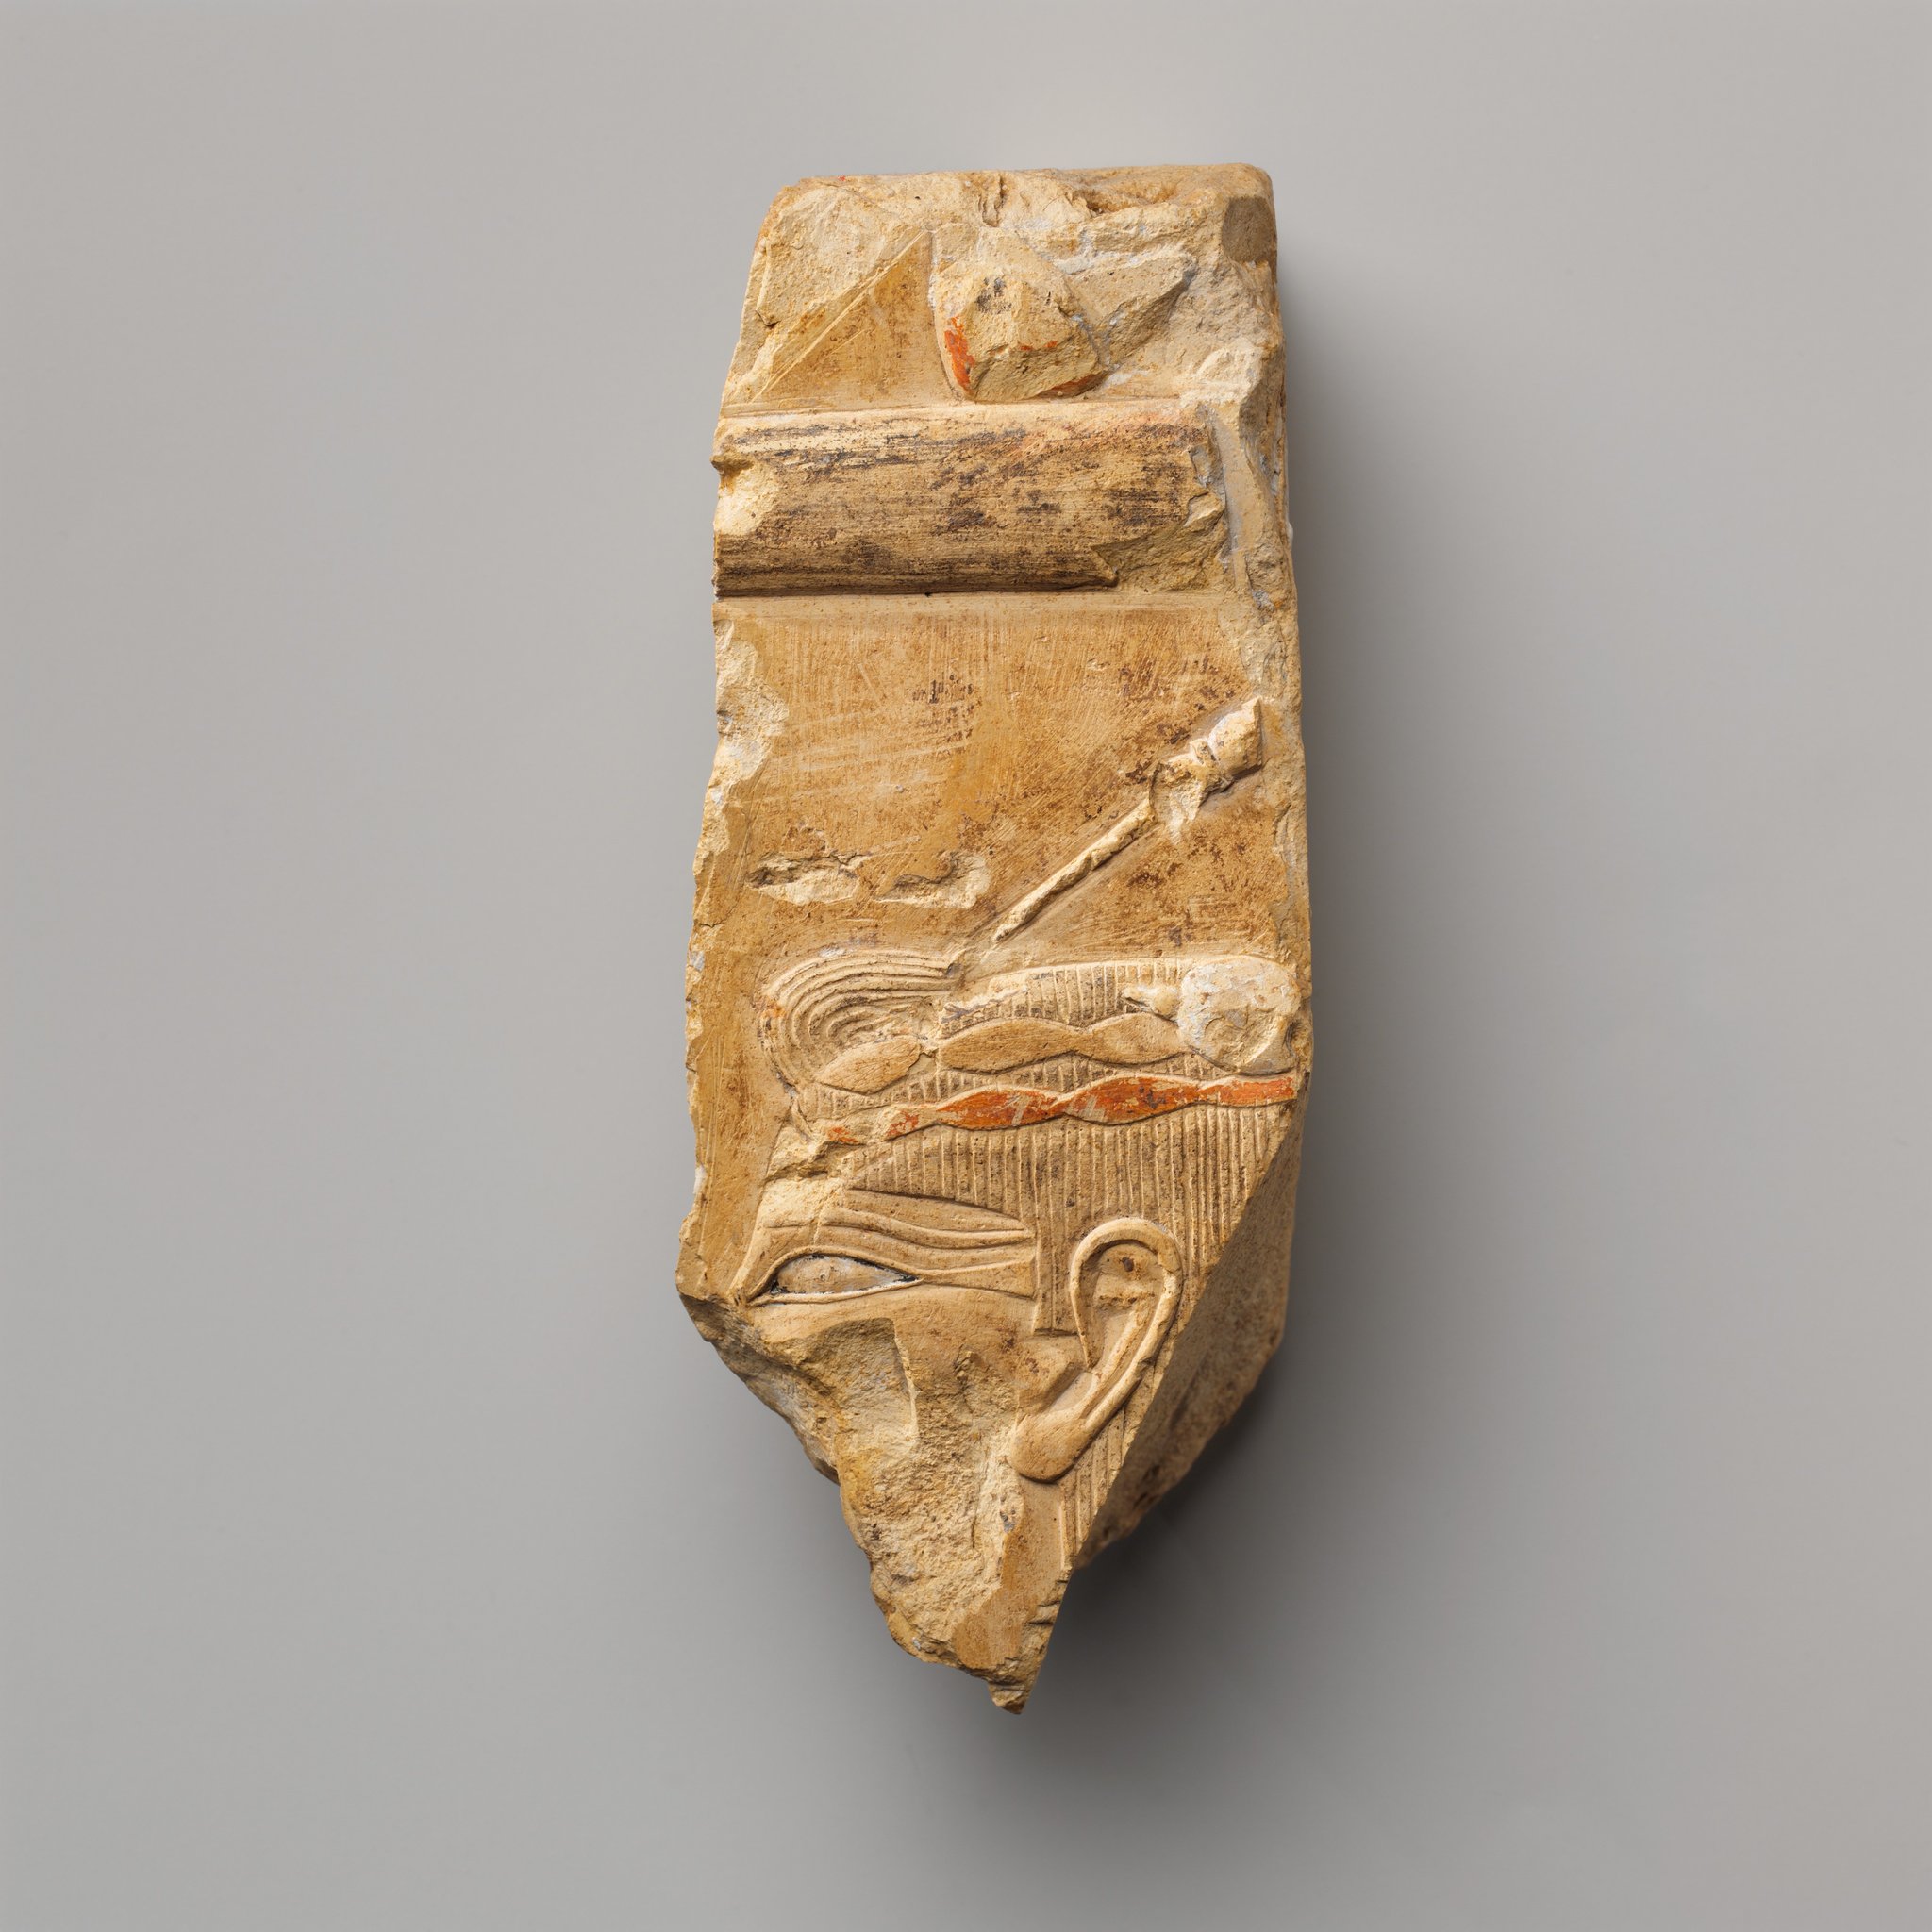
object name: relief, neferu, hairpin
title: Relief of a woman with a hairpin - see 26.3.353-5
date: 2051-2030 BCE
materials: limestone, paint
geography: egypt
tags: women